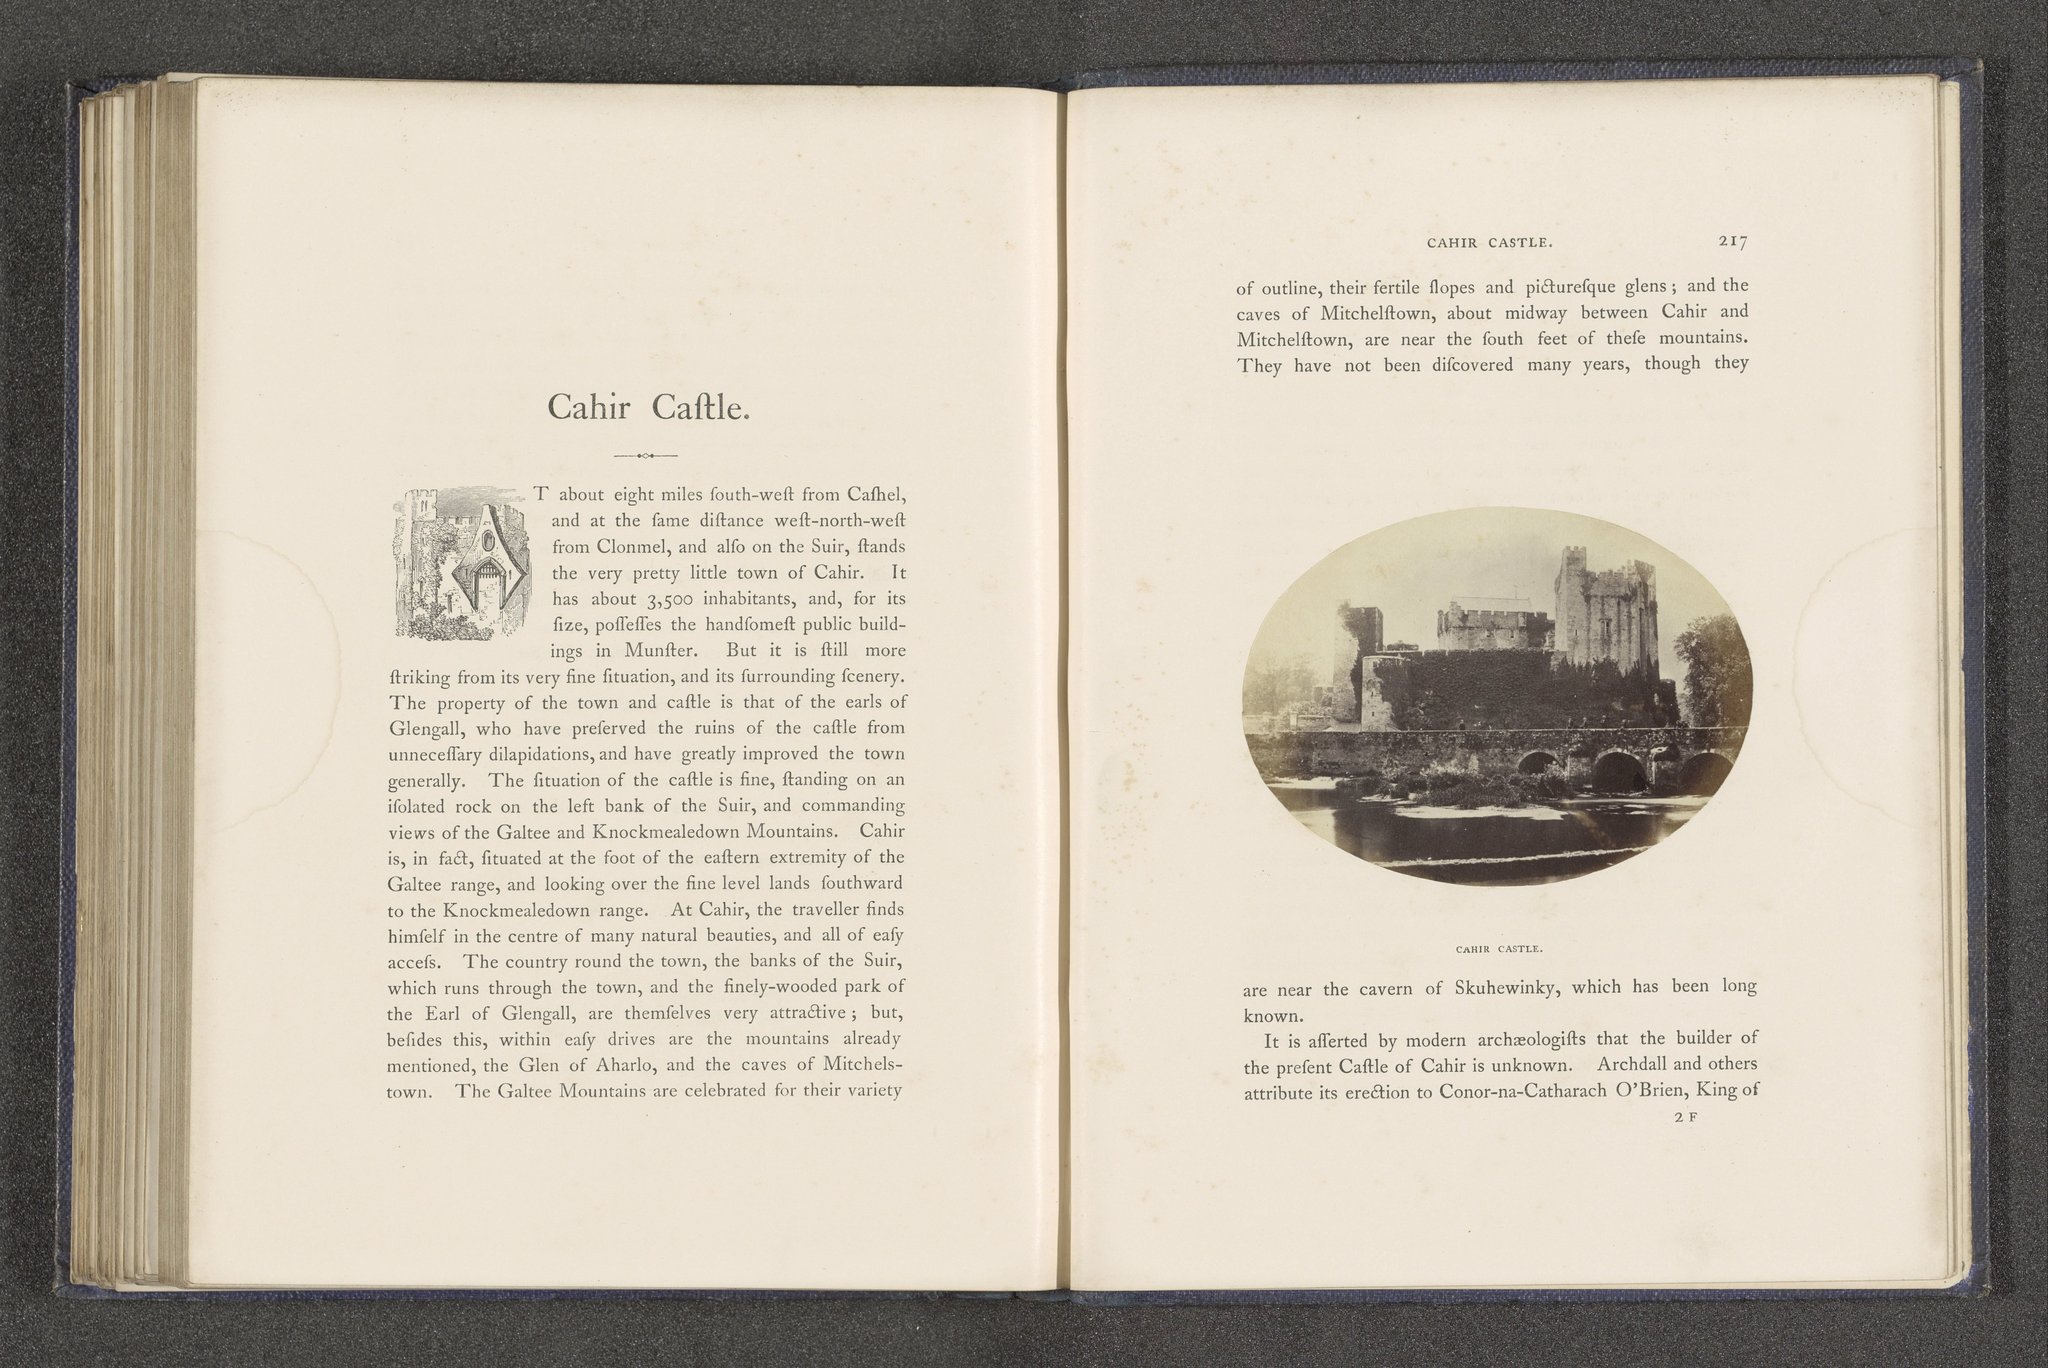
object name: page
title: Cahir Castle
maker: hemphill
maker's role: fotograaf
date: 1854-1864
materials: photographic support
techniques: albumen print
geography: cahir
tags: ruin of a dwelling, house, castle, etc.